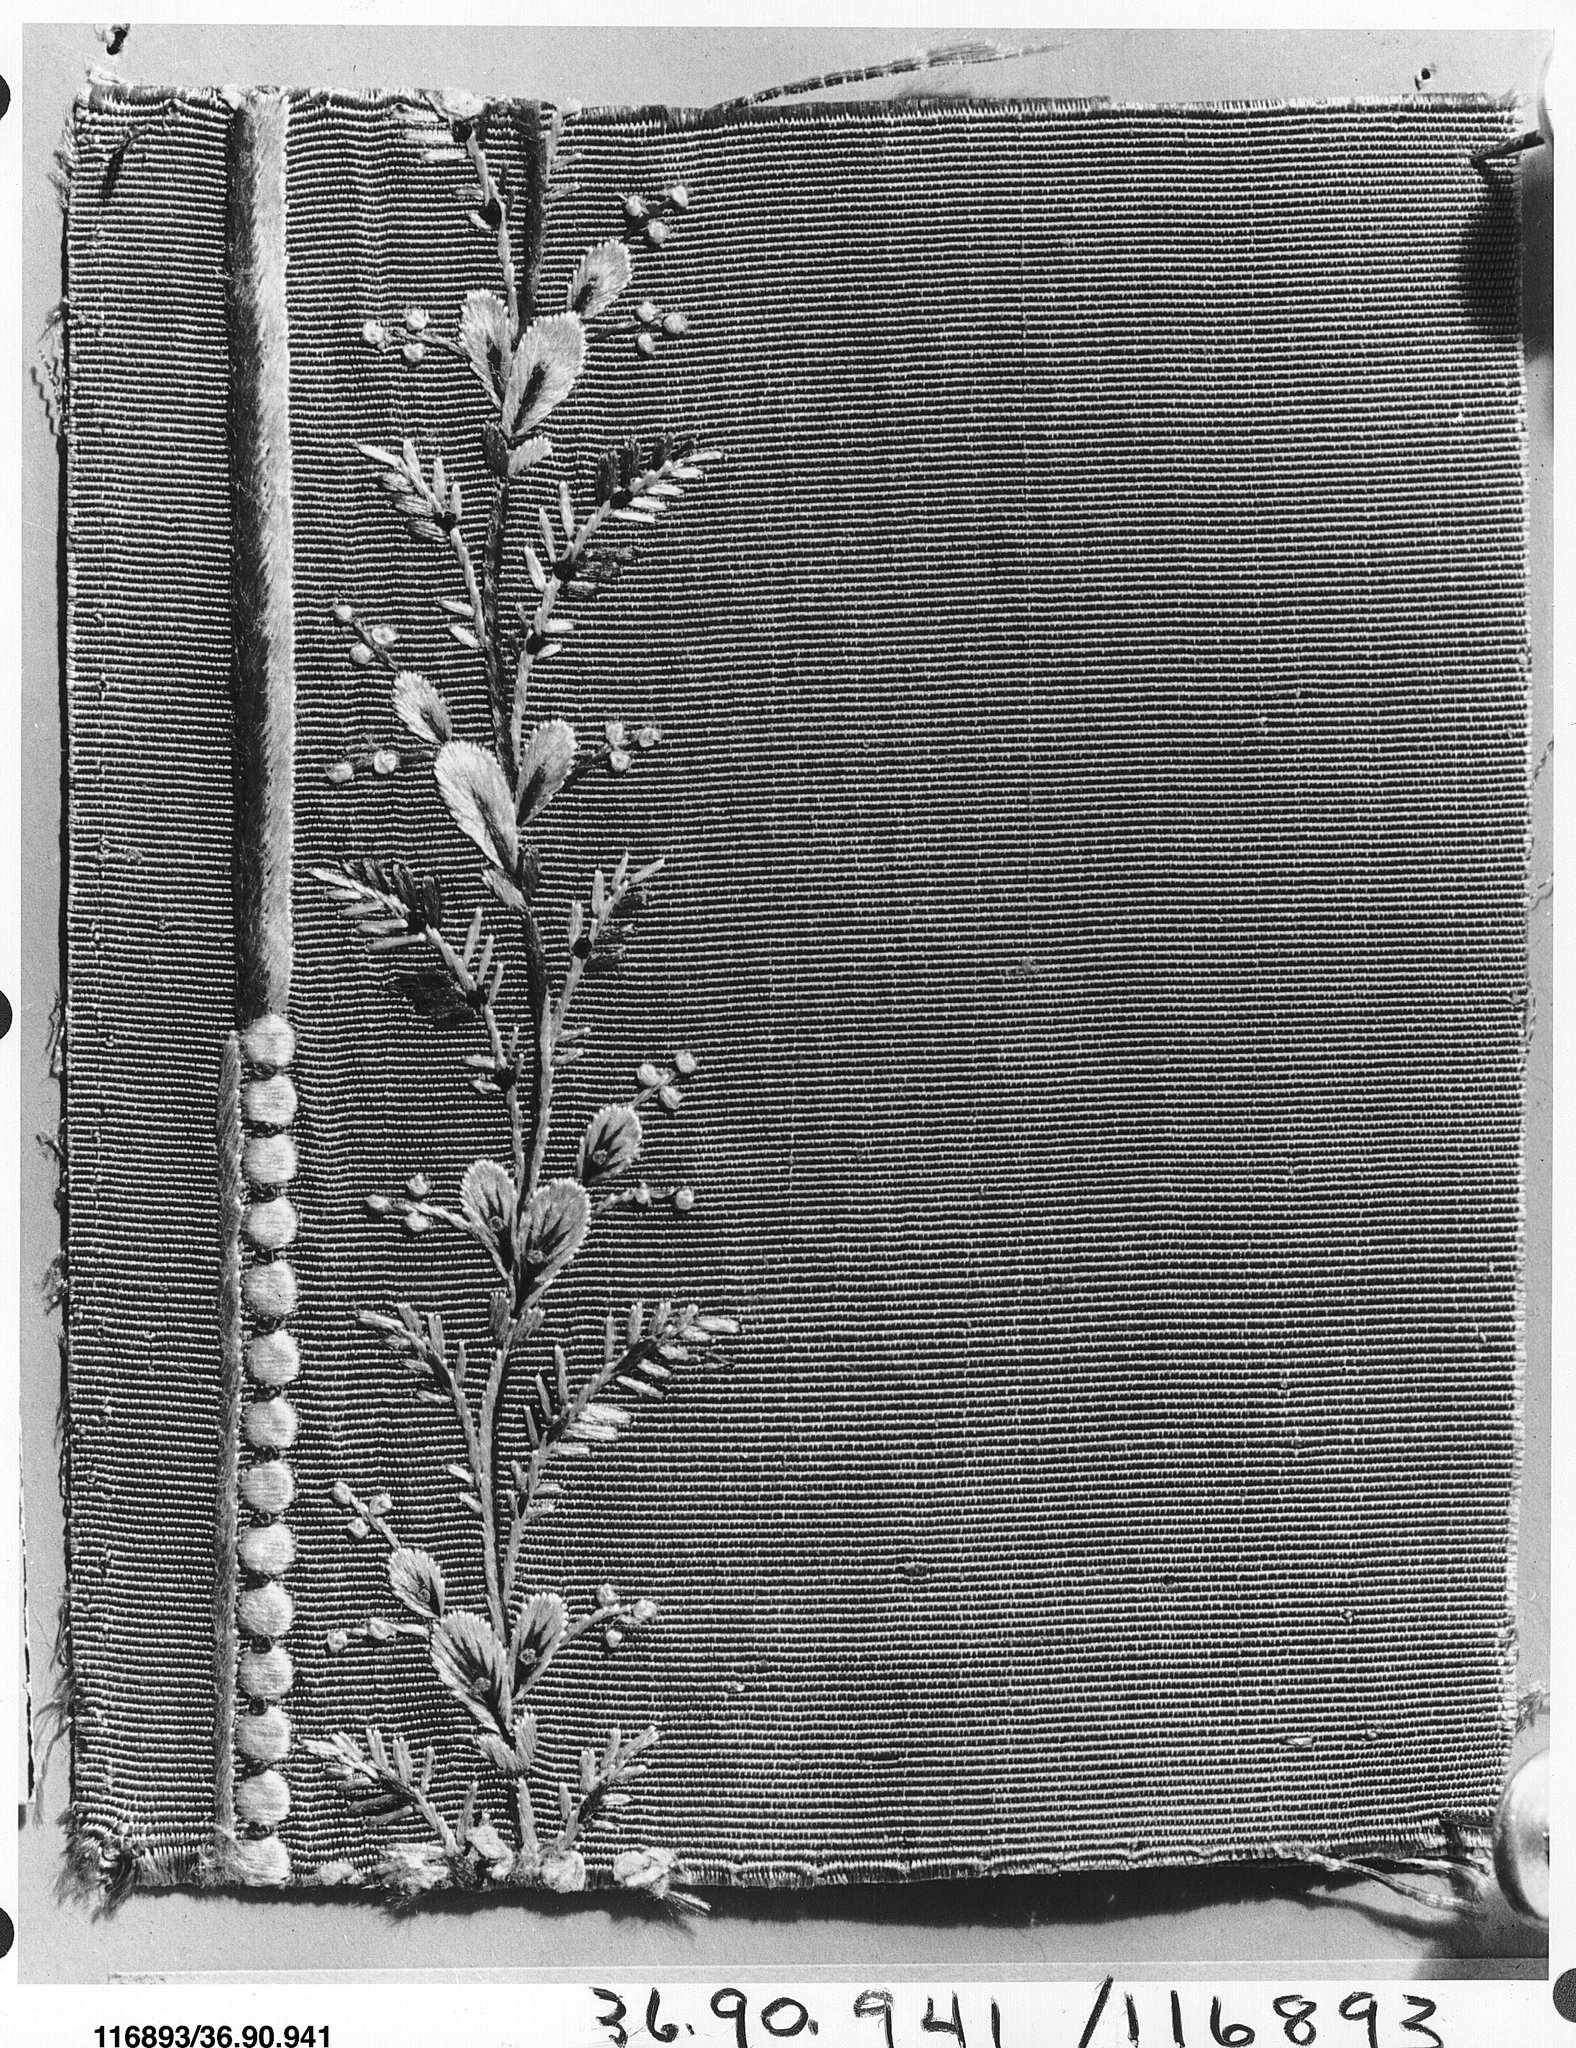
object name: sample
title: Embroidery sample for a man’s suit or waistcoat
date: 1785-1815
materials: silk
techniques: embroidery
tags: flowers